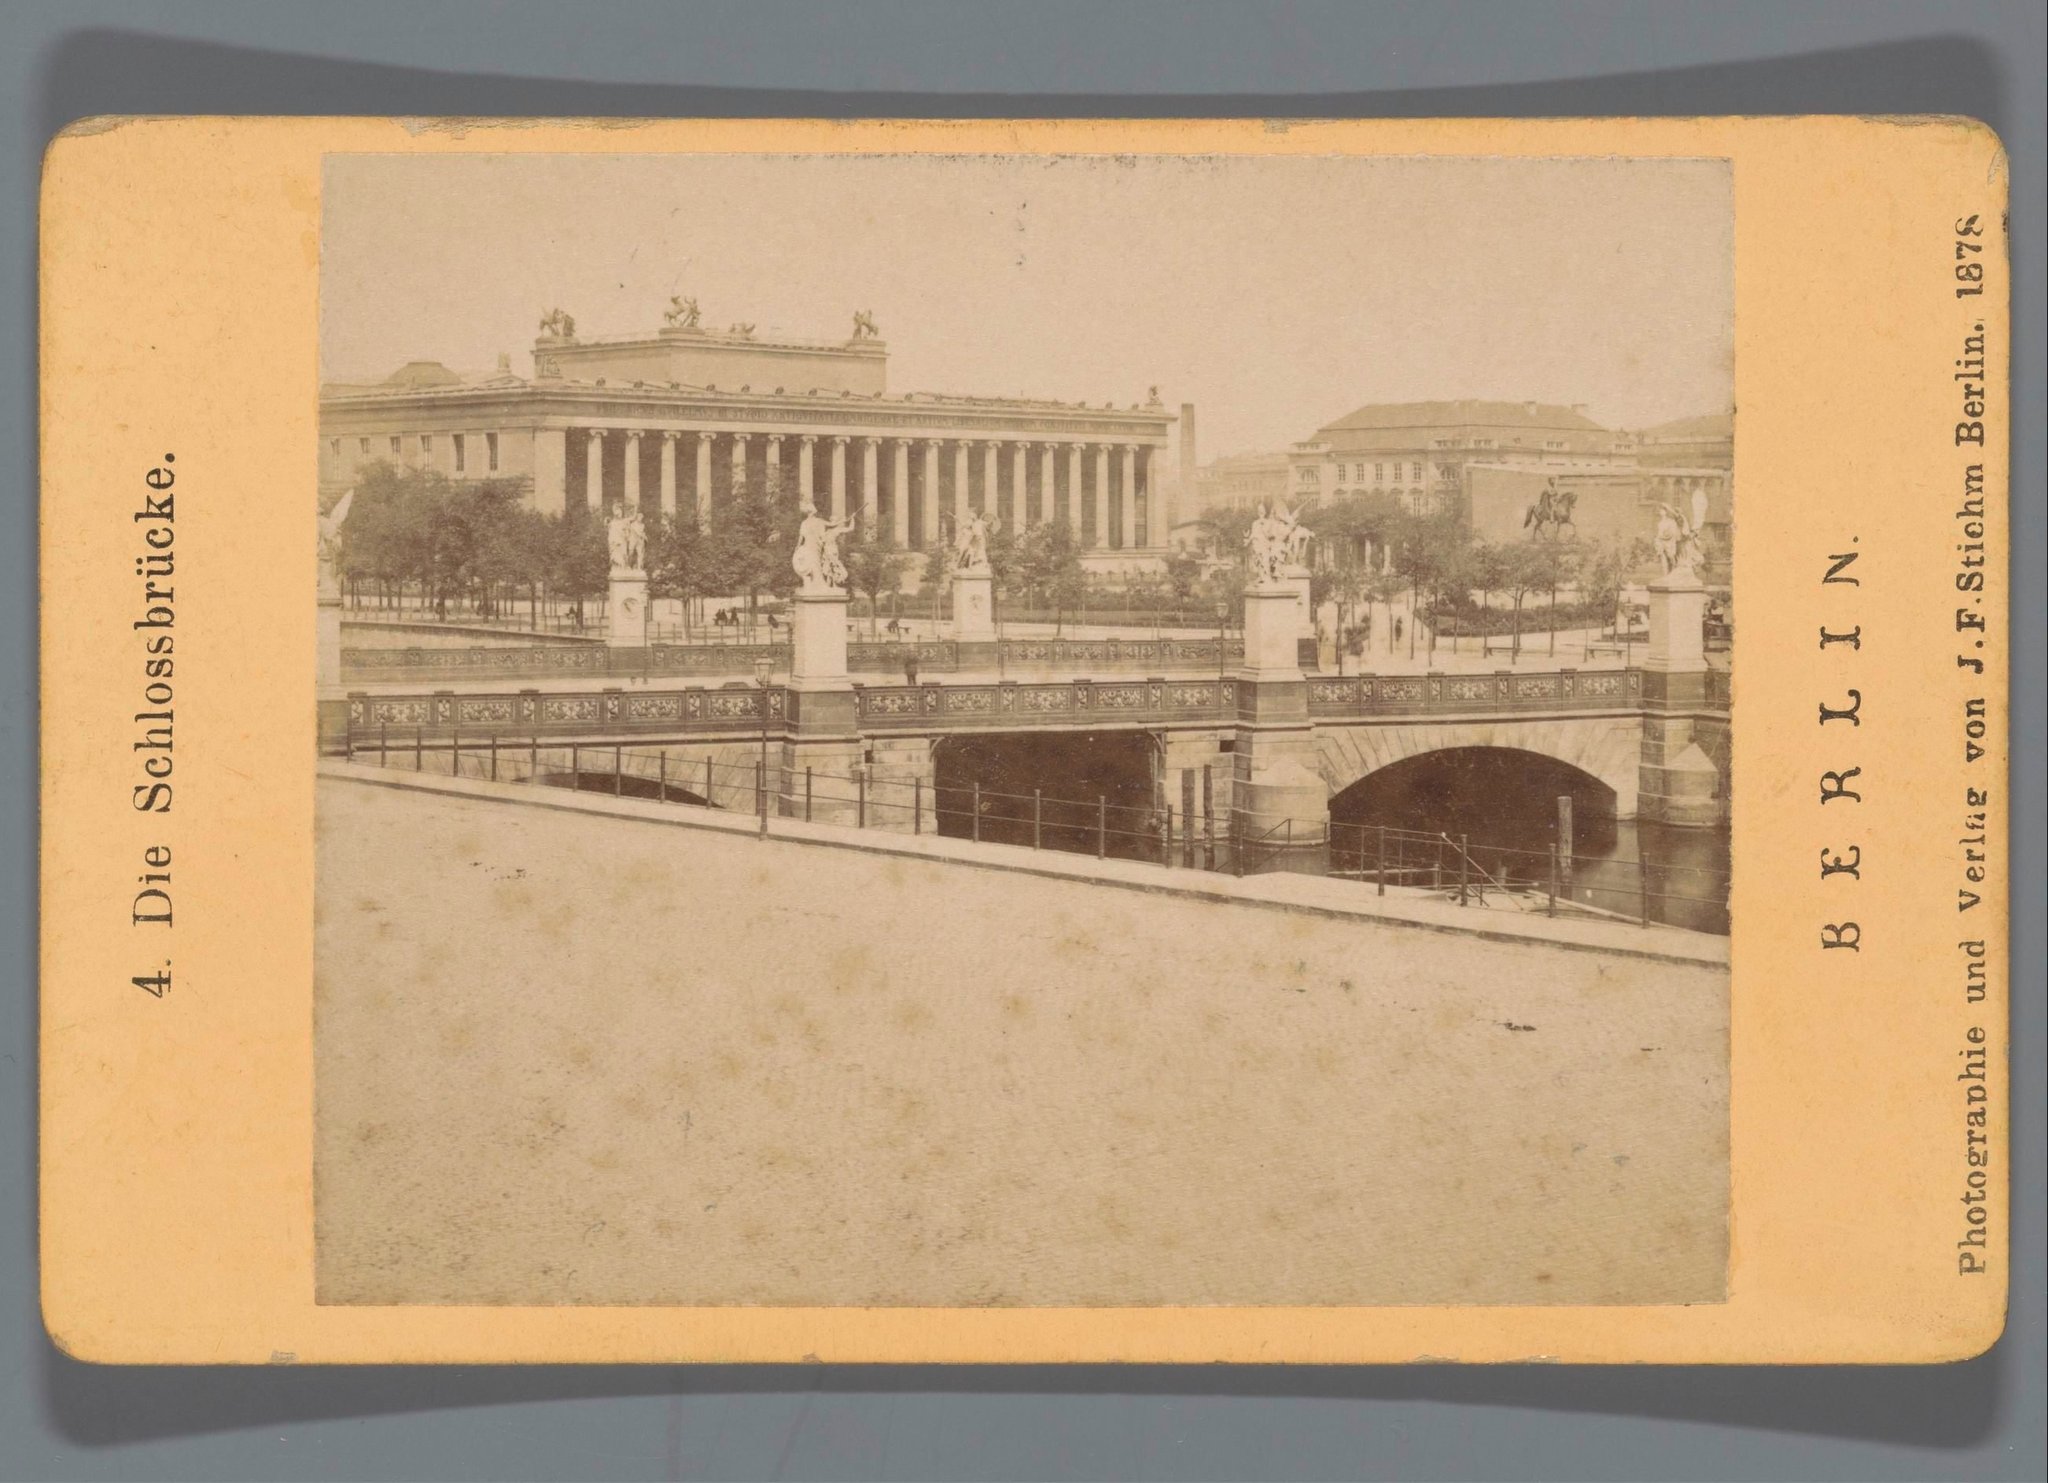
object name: photograph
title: Die Schlossbrücke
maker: johann friedrich stiehm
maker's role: fotograaf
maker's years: 1826-1902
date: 1878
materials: cardboard, paper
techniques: albumen print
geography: berlin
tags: bridge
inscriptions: number: ‘4.’